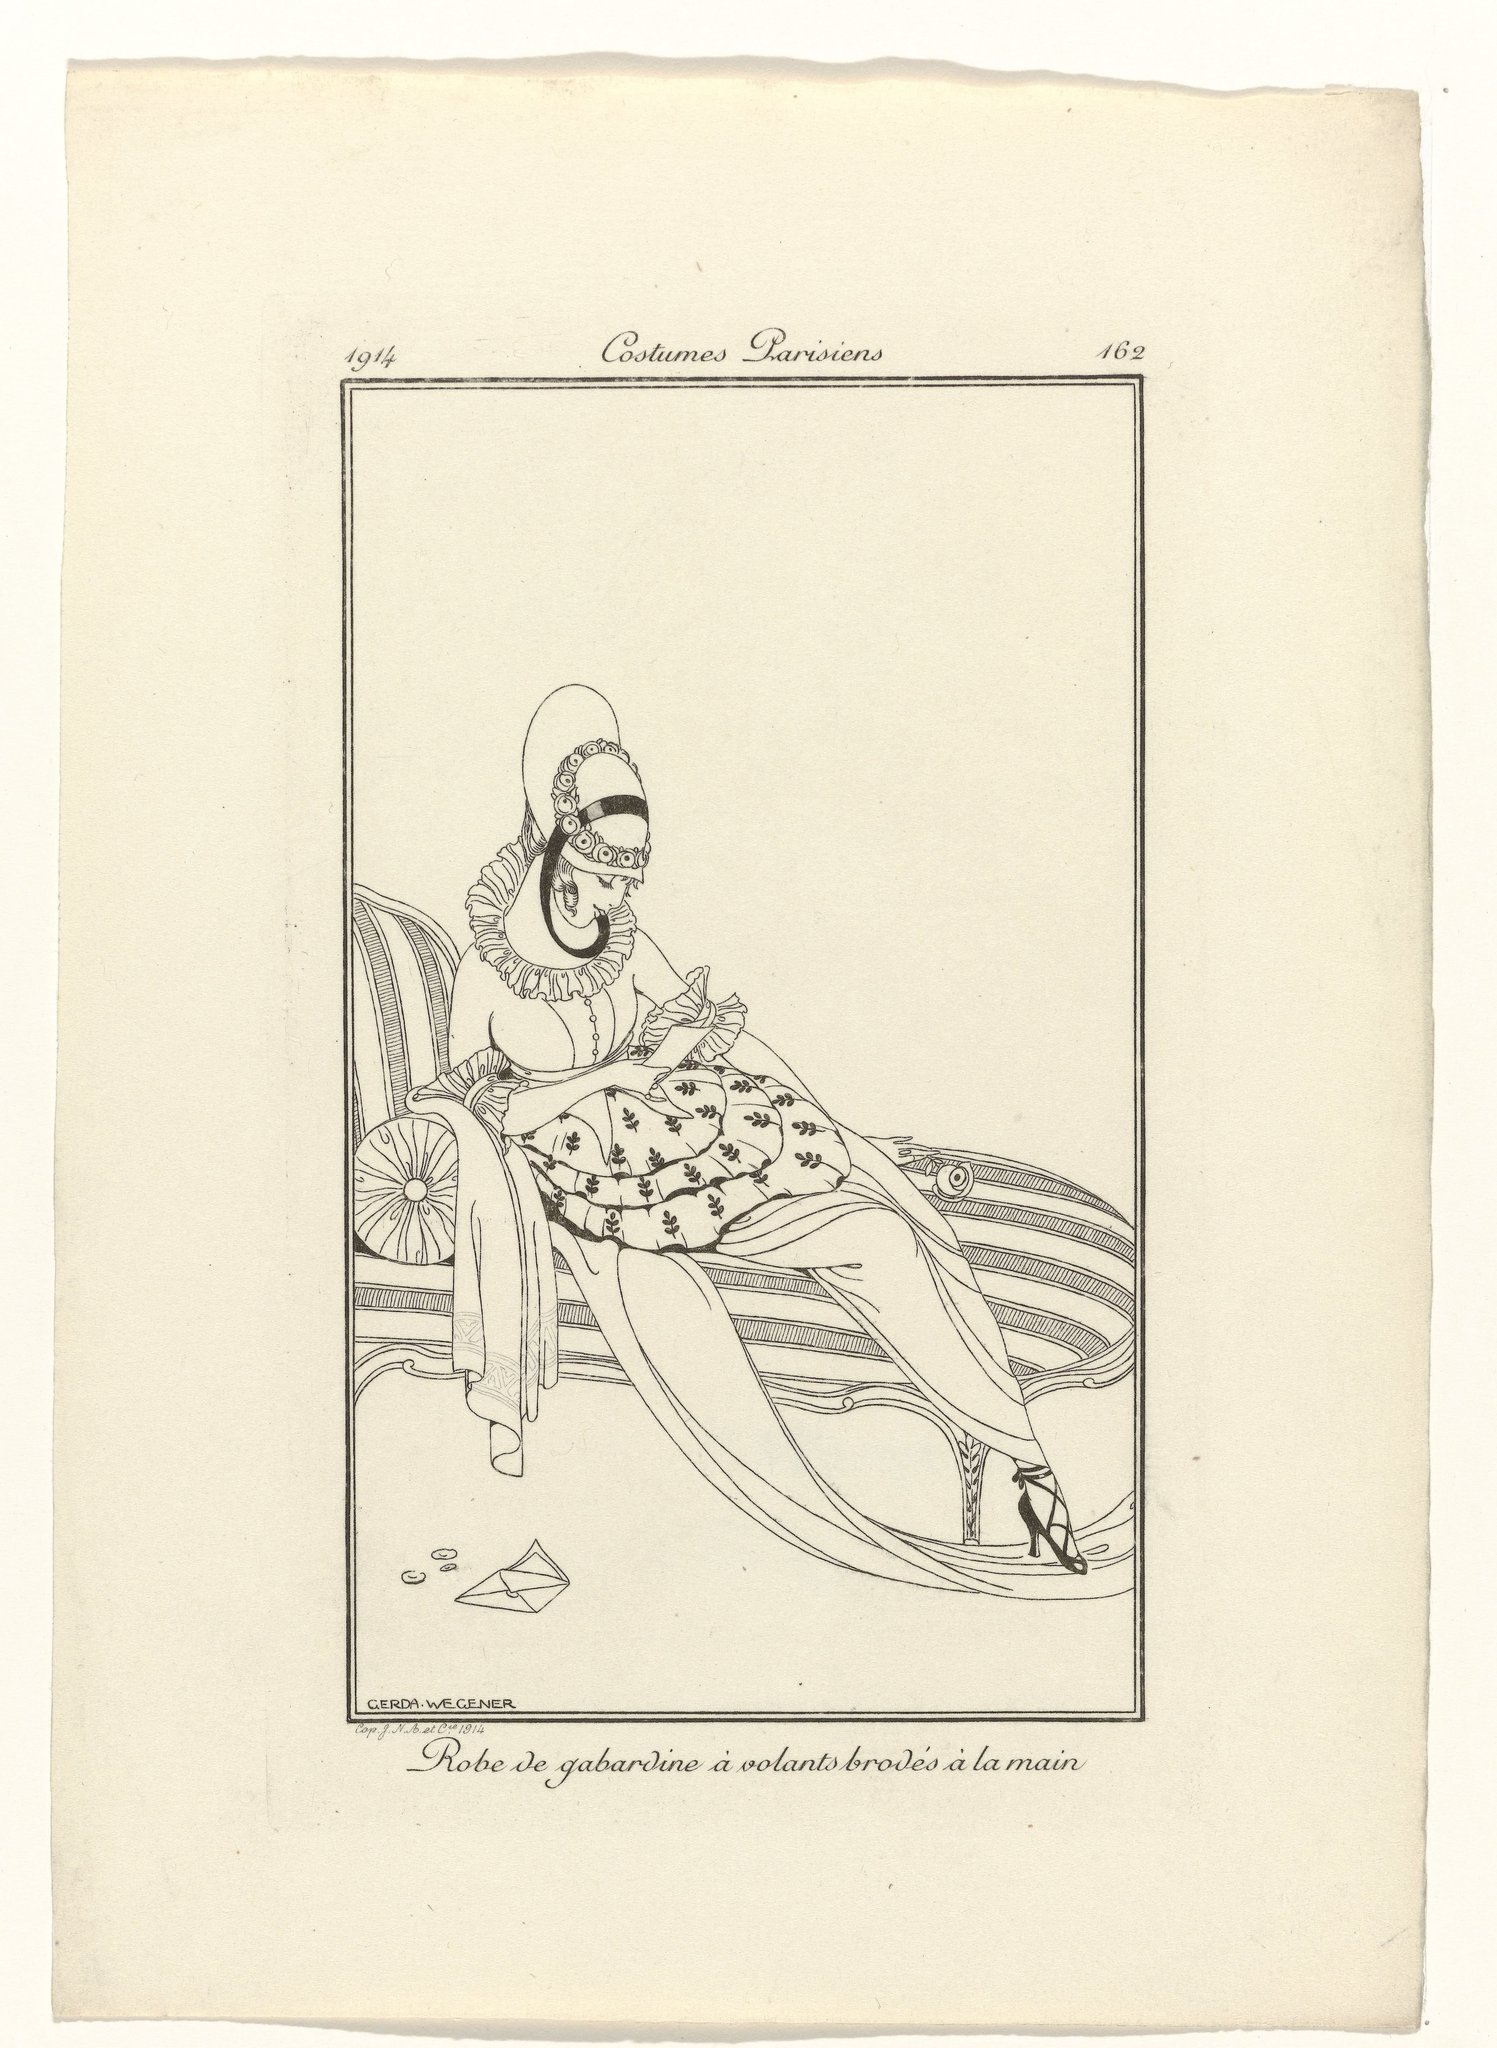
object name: fashion print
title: Journal des Dames et des Modes, Costumes Parisiens, 1914, No. 162 : Robe de gabardin (...)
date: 1914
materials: paper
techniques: engraving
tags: flowers, clothing for the upper part of the body (shawl) (+ women's clothes), reading, embroidery (ornamentation) (+ women's clothes), fashion plates, head-gear: hat (+ women's clothes), dress, gown (+ women's clothes), letter, envelope, couch, sofa, settee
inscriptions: inscription: ‘Cop. J. N. A. et Cie 1914’, caption: ‘Robe de gabardine a volants brodés à la main.’, title: ‘Costumes Parisiens’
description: Vrouw, zittend op een chaise longue, gekleed in een japon van gabardine met geplooide stroken die met de hand zijn geborduurd. Proefdruk van een prent uit het modetijdschrift Journal des Dames et des Modes (1912-1914).